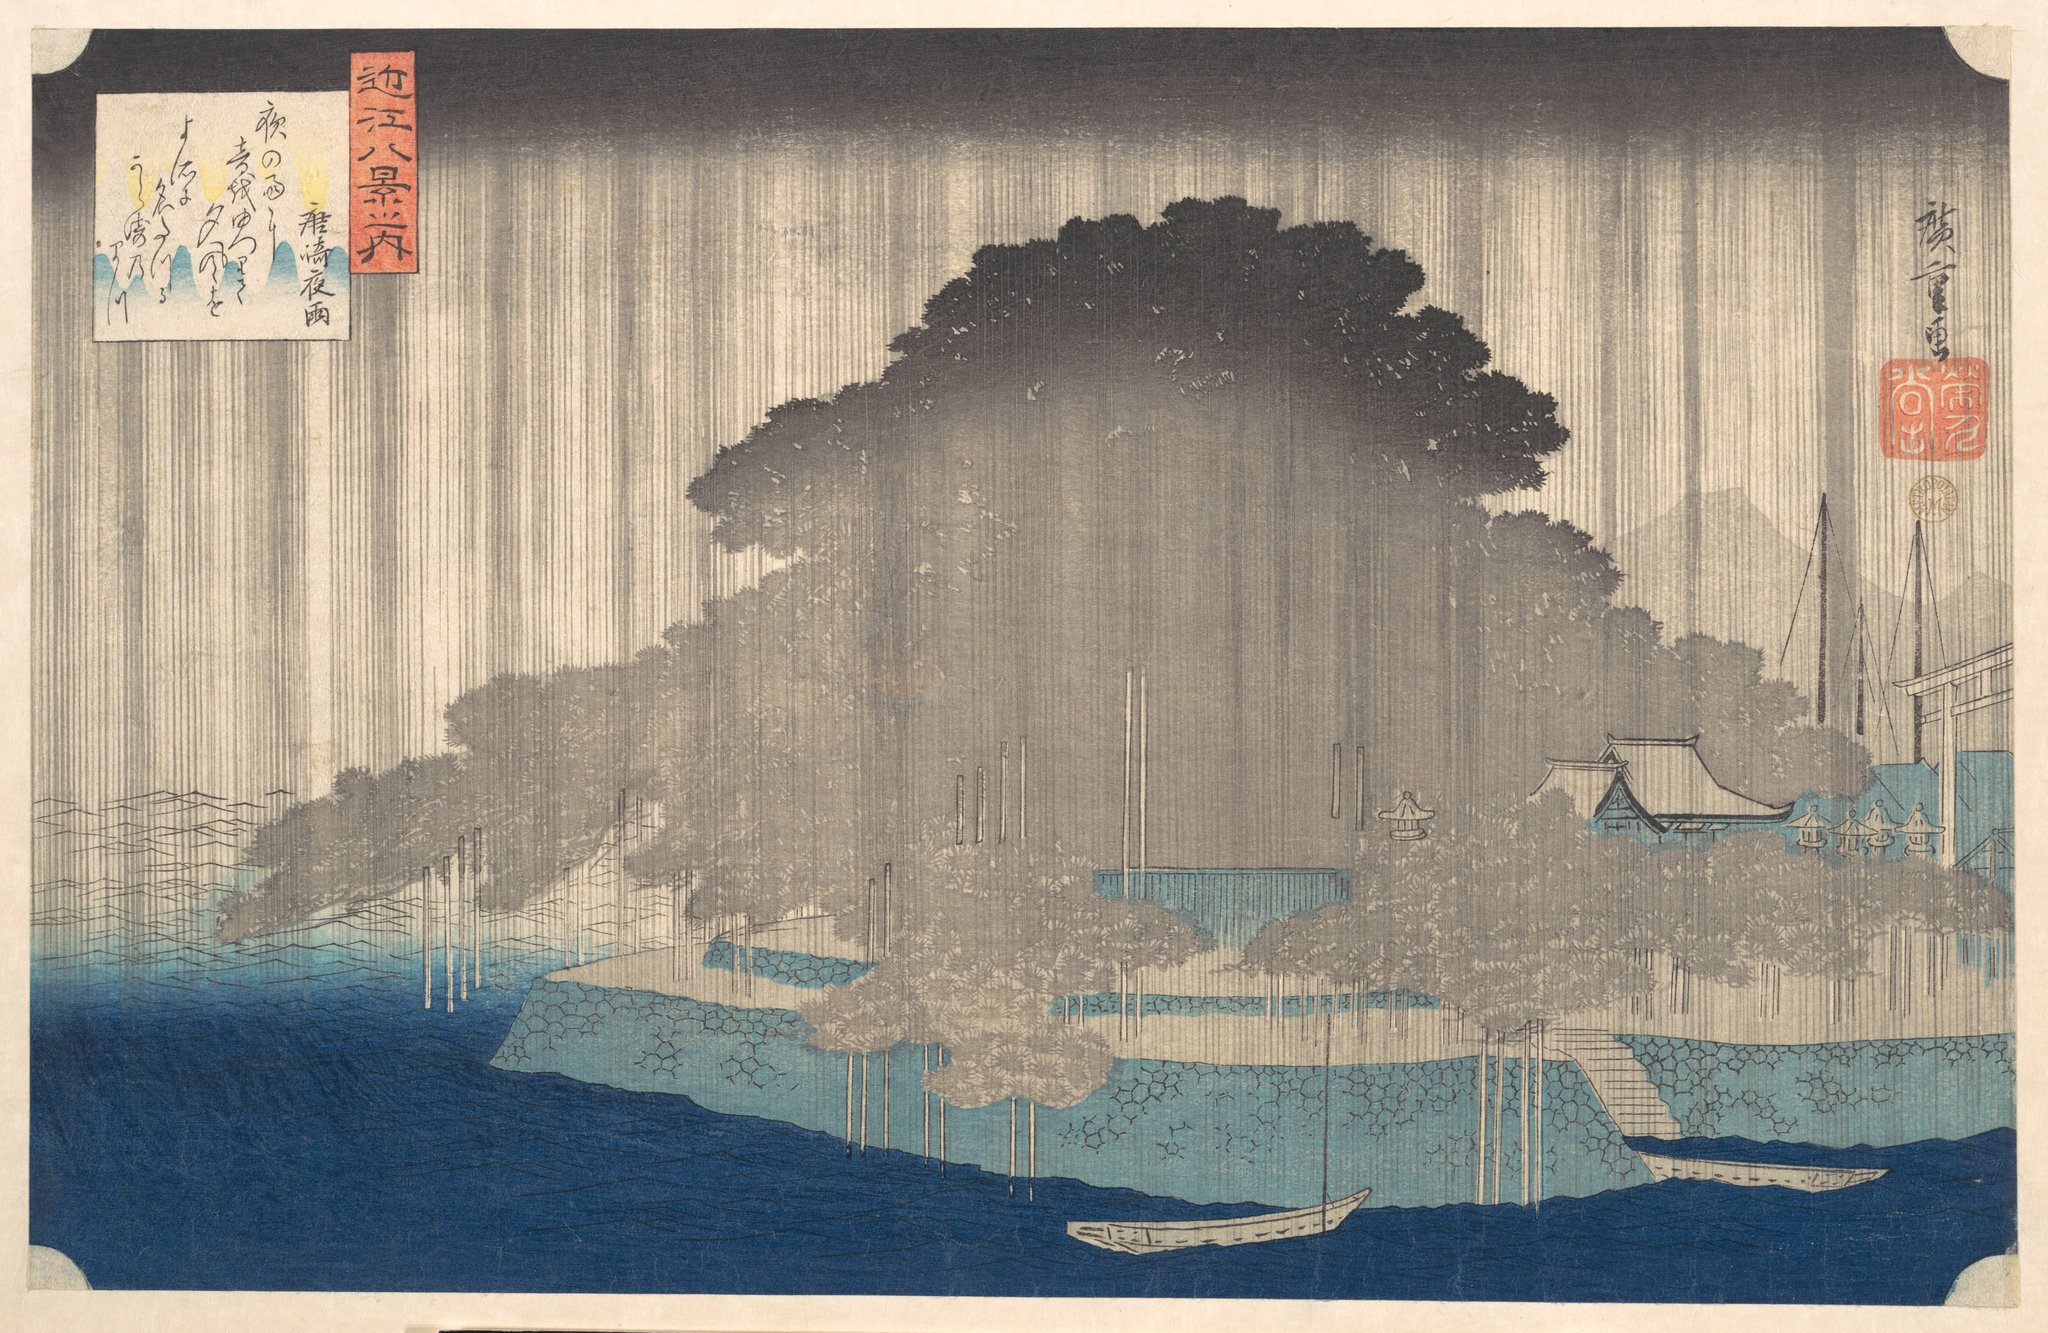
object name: print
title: Night Rain at Karasaki, from the series Eight Views of Ōmi (Ōmi hakkei no uchi)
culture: japanese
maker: utagawa hiroshige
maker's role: artist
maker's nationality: japanese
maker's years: 1797-1858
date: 1835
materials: ink, paper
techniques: woodblock print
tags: houses,trees,rain,boats